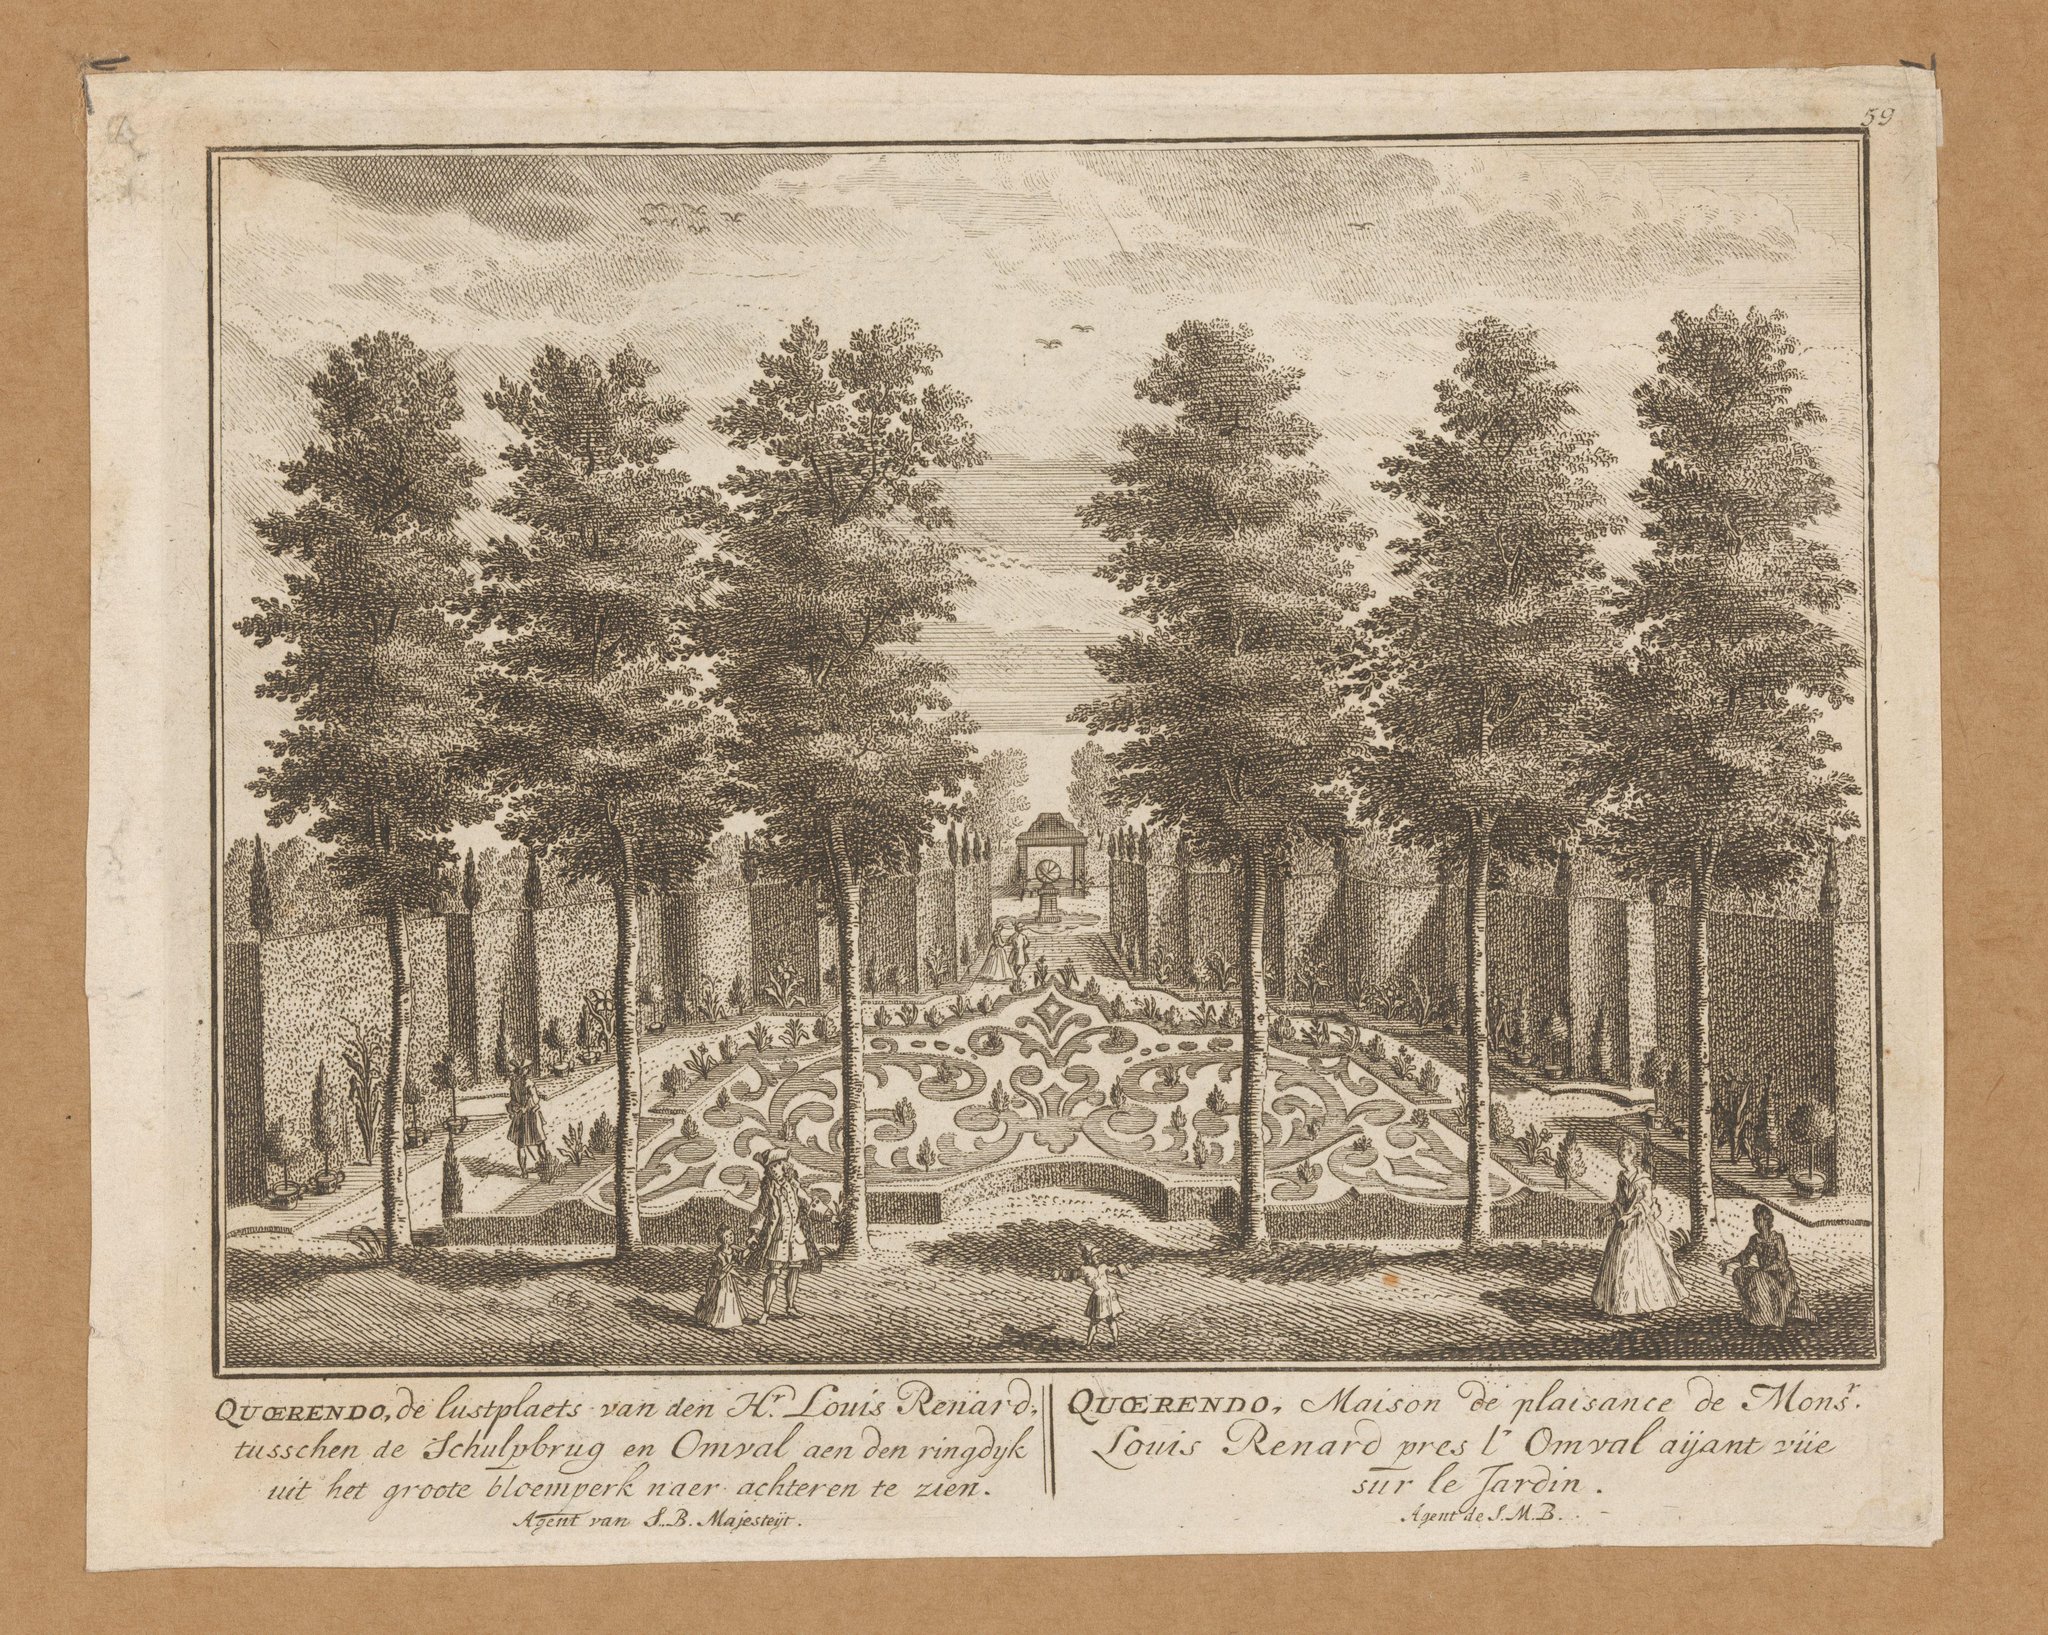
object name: print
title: Quoerendo, de lustplaets van de Hr. Louis Renard tusschen de Schulpbrug en Omval aen den ringdijk uit het groote bloemperk naer achteren te zien / Quoerendo, Maison de plaisance de Monsr. Louis Renard pres l'Omval aijant vüe sur le Jardin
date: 1725-1768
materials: paper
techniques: engraving, etching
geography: amsterdam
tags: french or architectonic garden; formal garden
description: Prent gebruikt in: Niedek, Mattaeus Brouërius. Het verheerlykt Watergraafs- of Diemermeer by de stadt Amsterdam (...). Amsterdam: Andries en Hendrik de Leth, 1725. Of in: Niedek, Mattaeus Brouërius. Het verheerlykt Watergraafs- of Diemermeer by de stadt Amsterdam (...). Amsterdam: Pieter Jan Entrop, 1768.